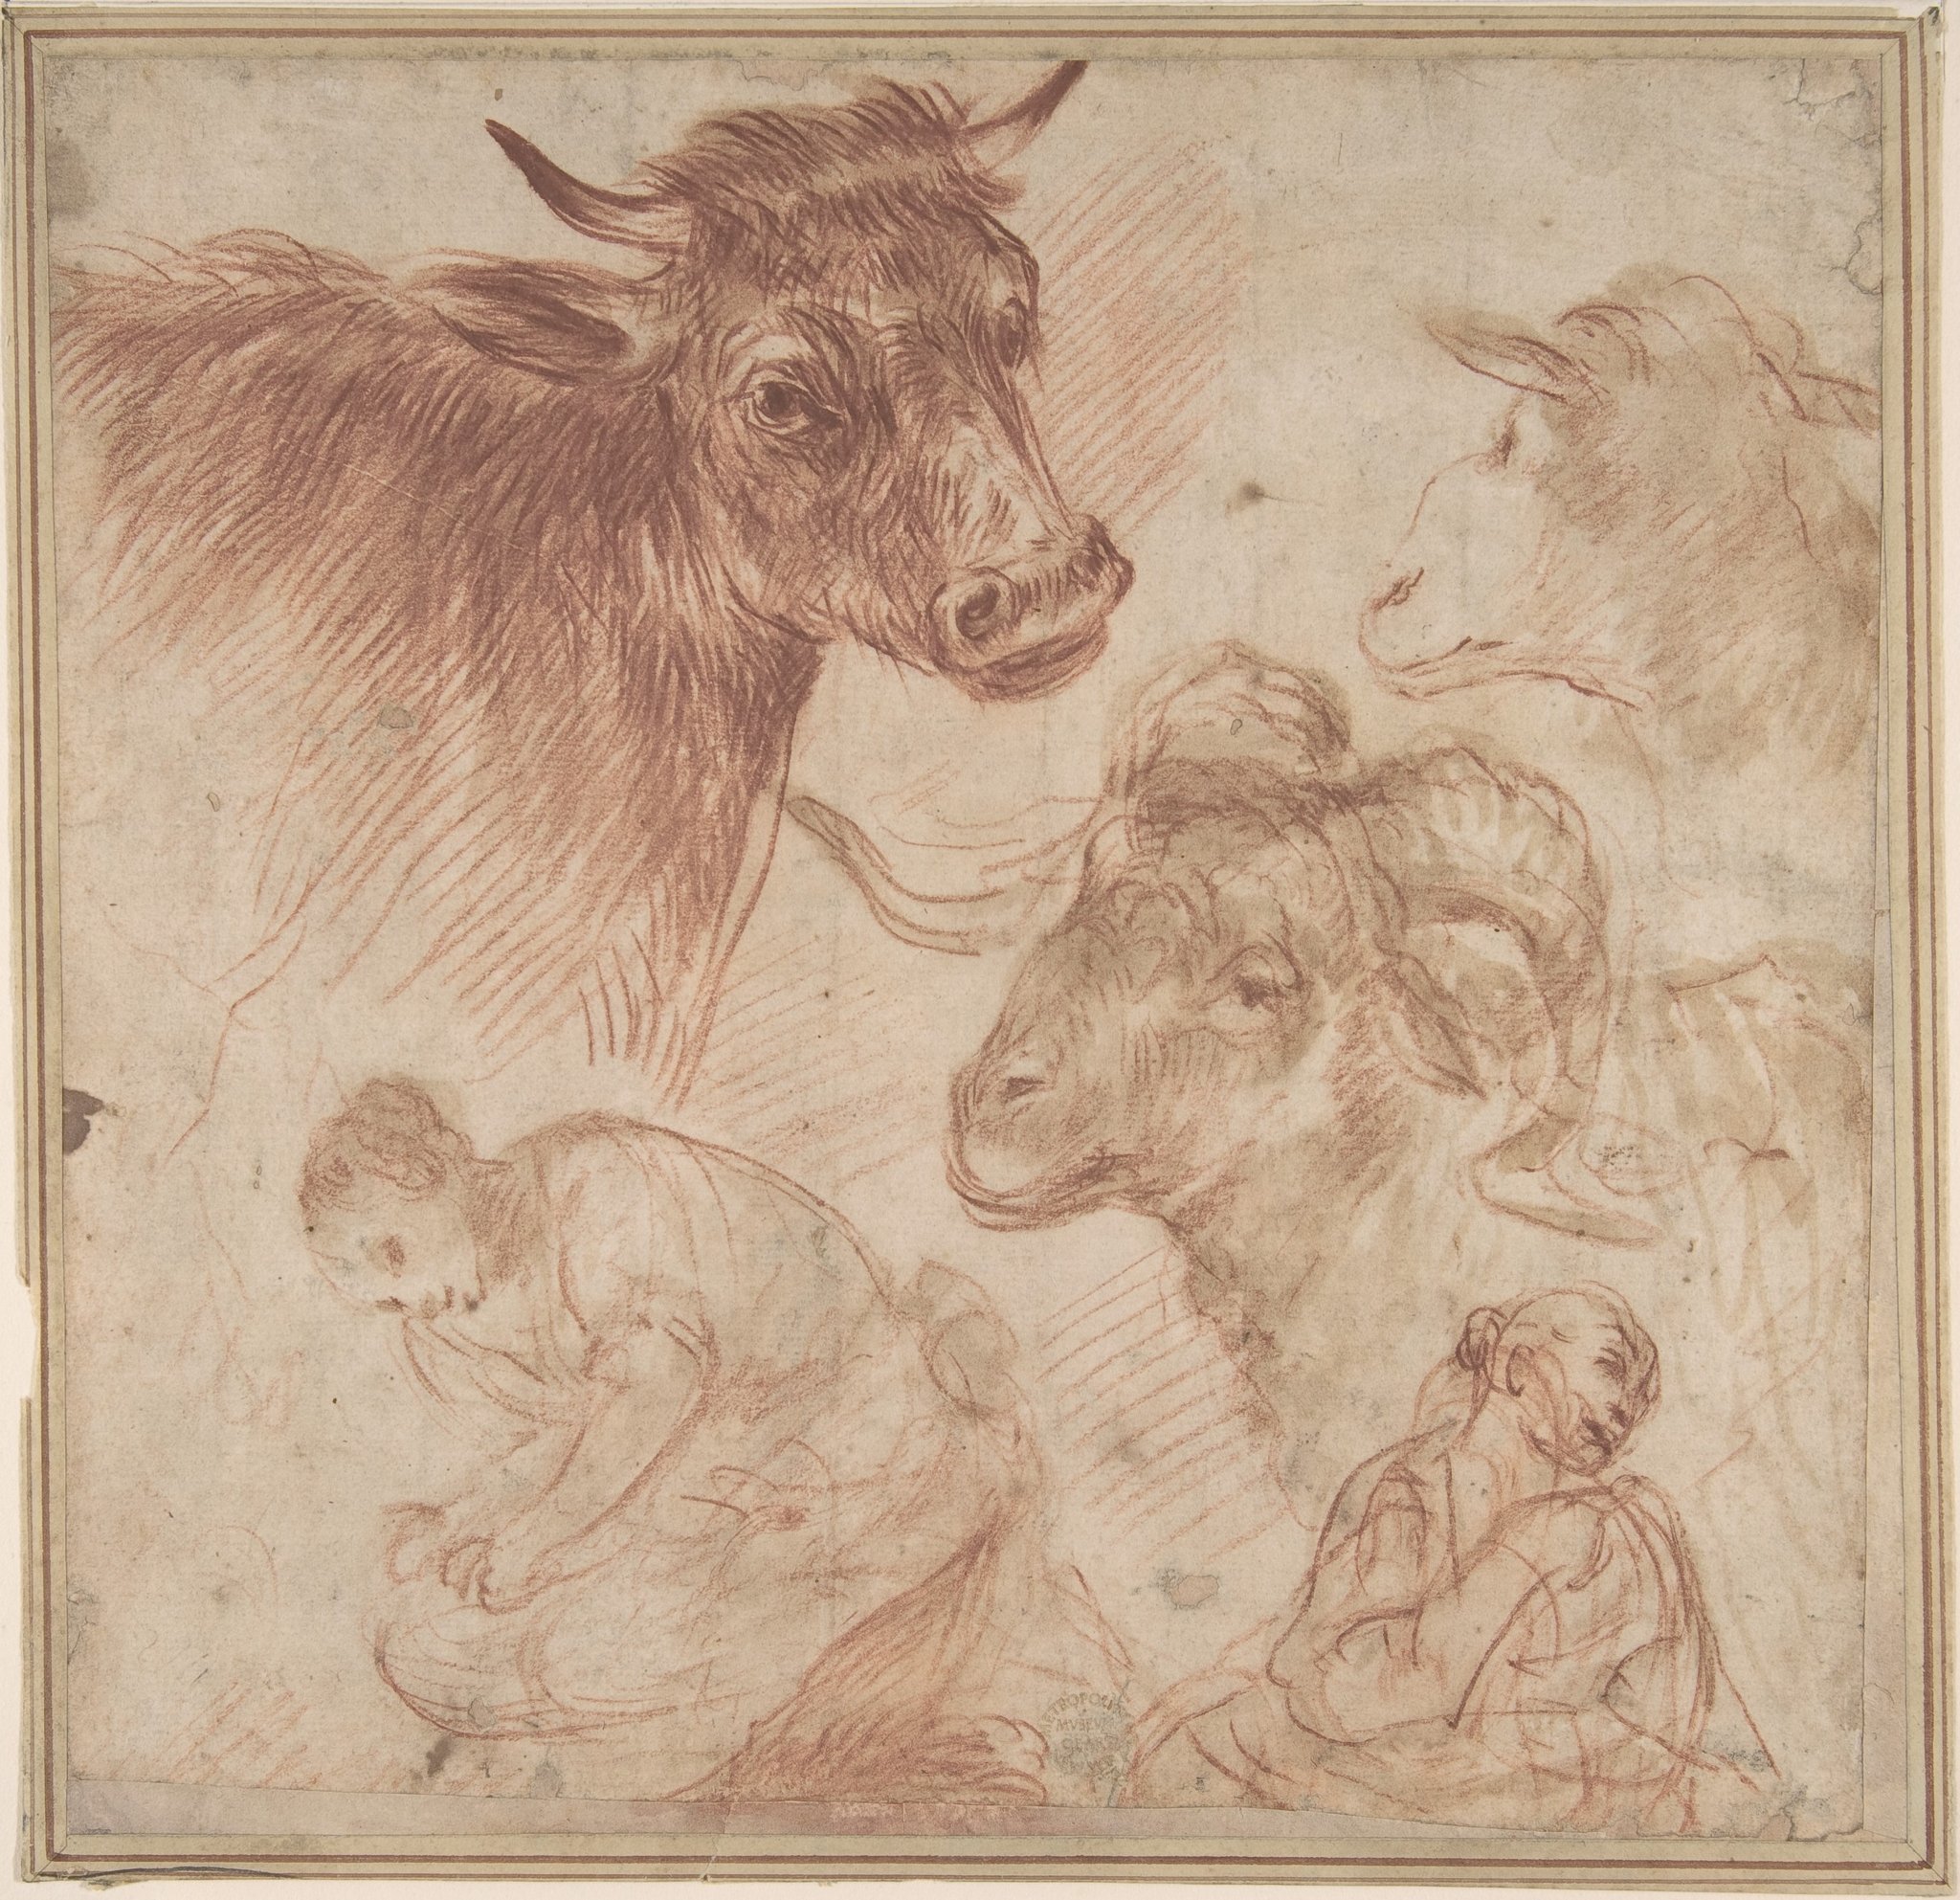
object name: drawing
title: Studies of Animal Heads and Figures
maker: anonymous, italian, roman-bolognese, 17th century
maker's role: artist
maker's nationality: italian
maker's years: 1600-1700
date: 1601-1700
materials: chalk, paper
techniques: brush, wash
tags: women,cows,rams